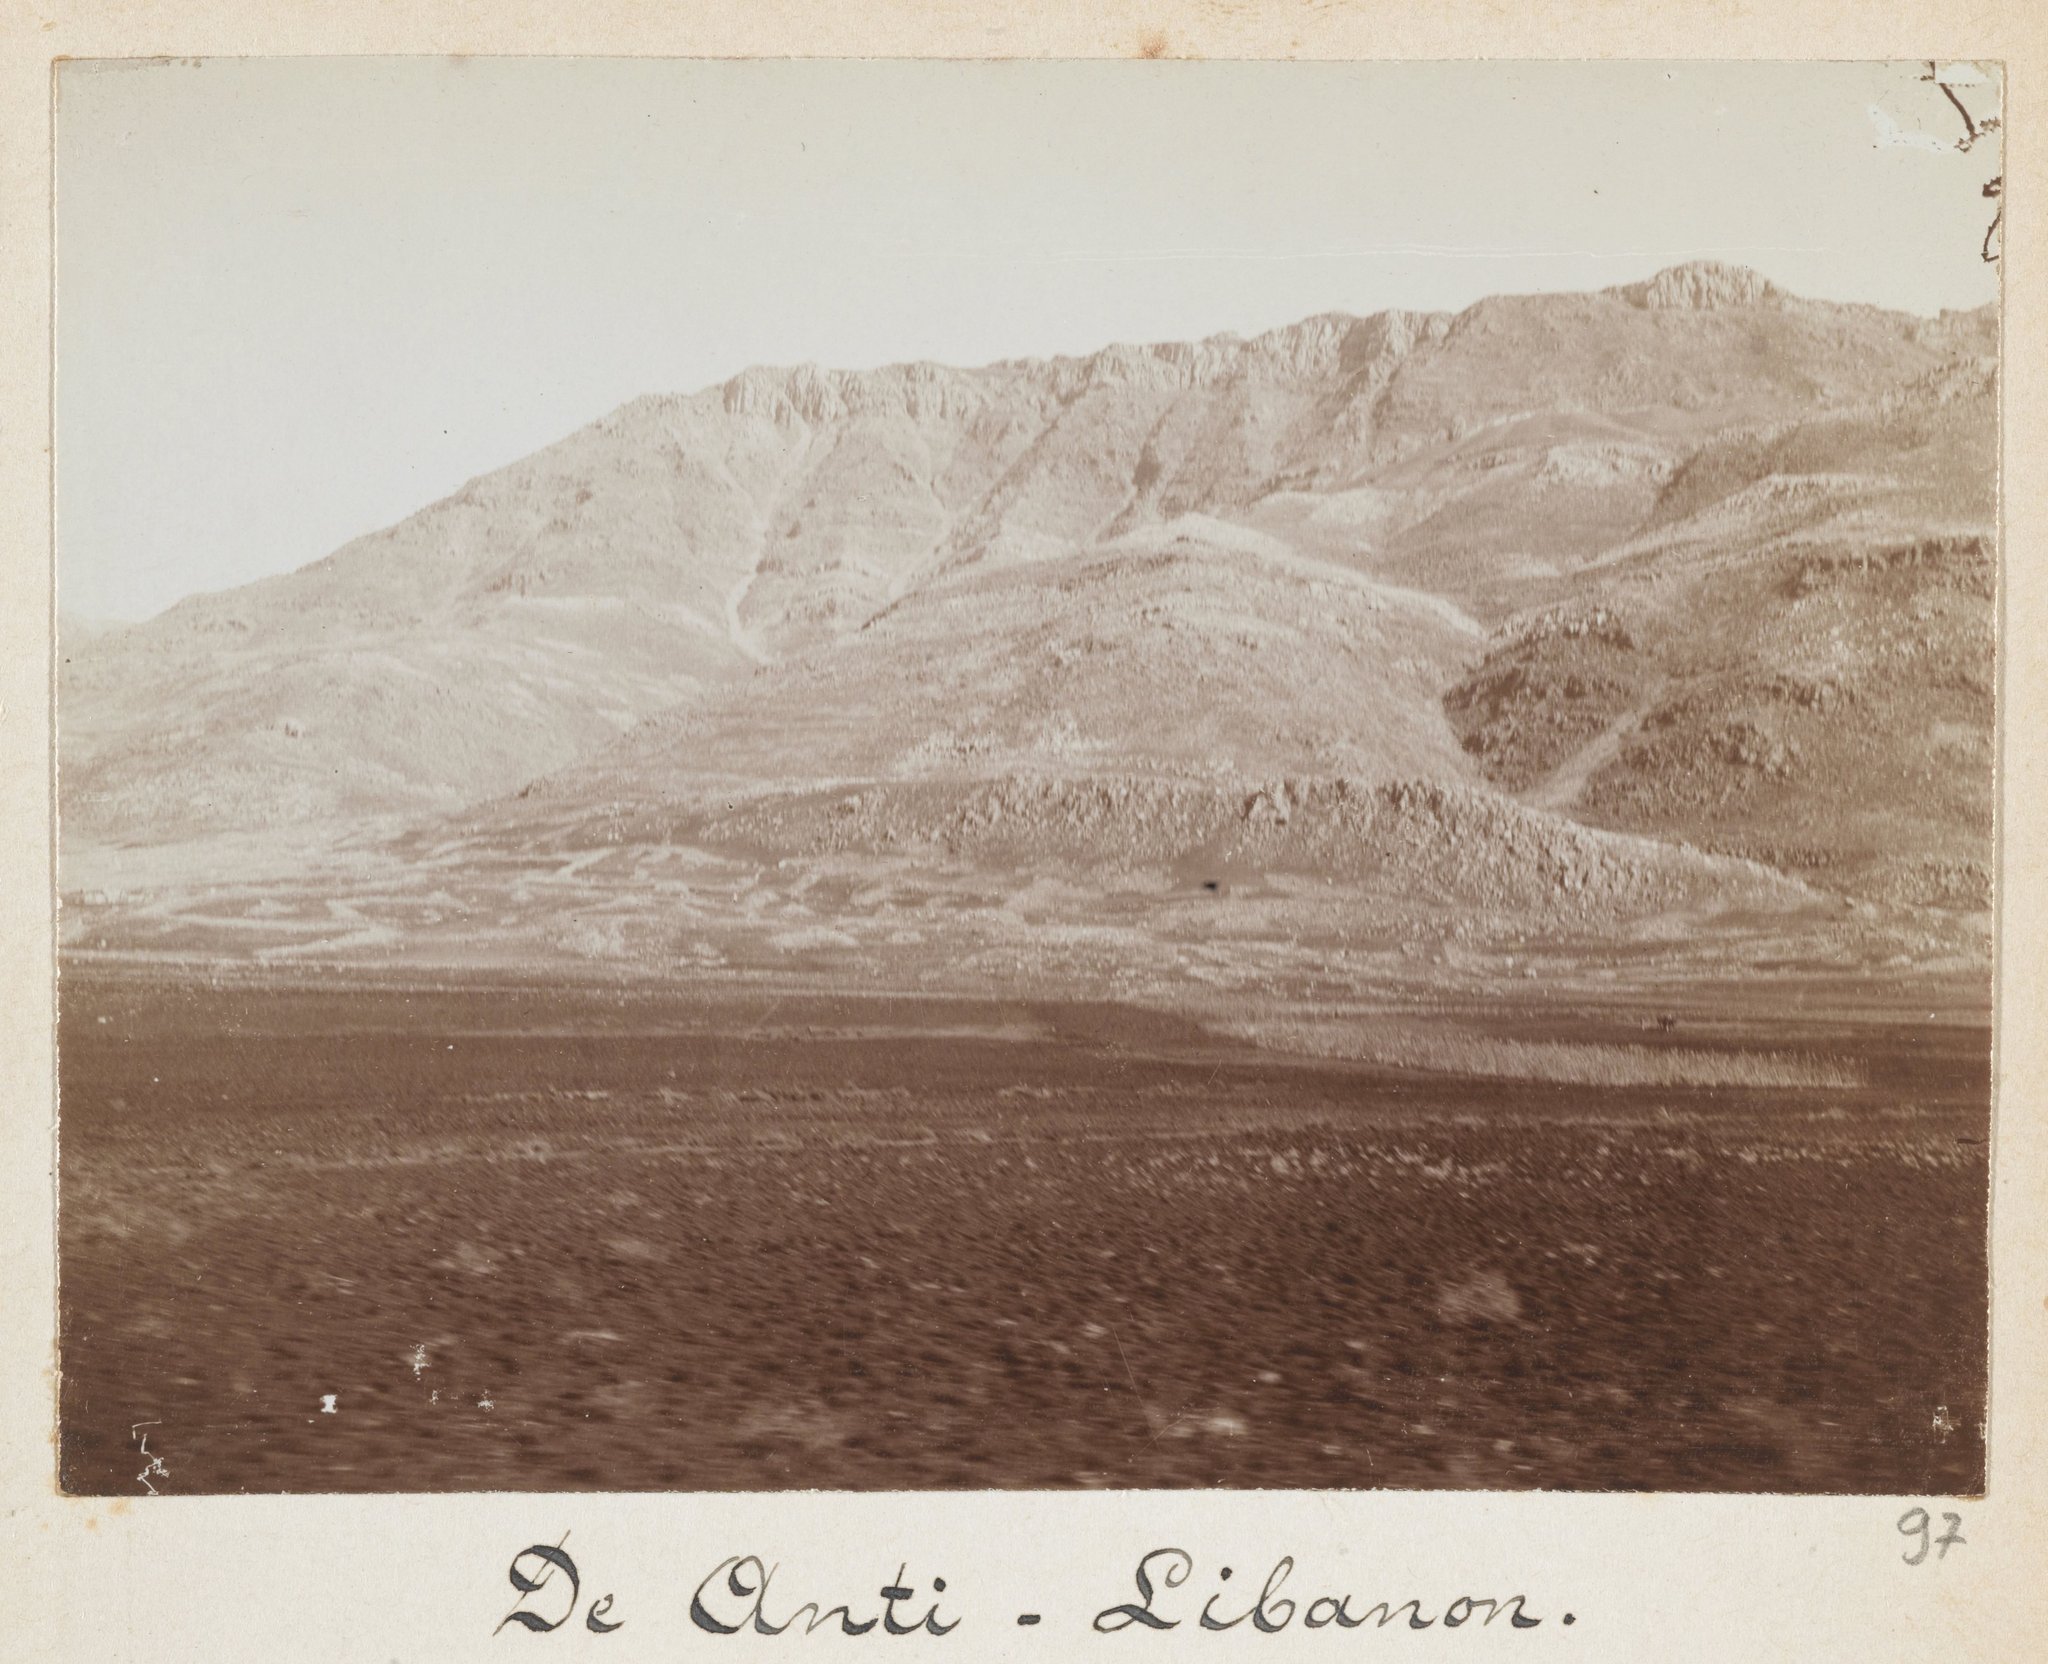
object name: photograph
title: De Anti-Libanon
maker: johannes lodewijk heldring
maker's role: fotograaf, predikant, schrijver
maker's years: 1852-1923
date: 1898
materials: paper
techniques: collodion silver print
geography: lebanon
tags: mountain-range, snow peaks